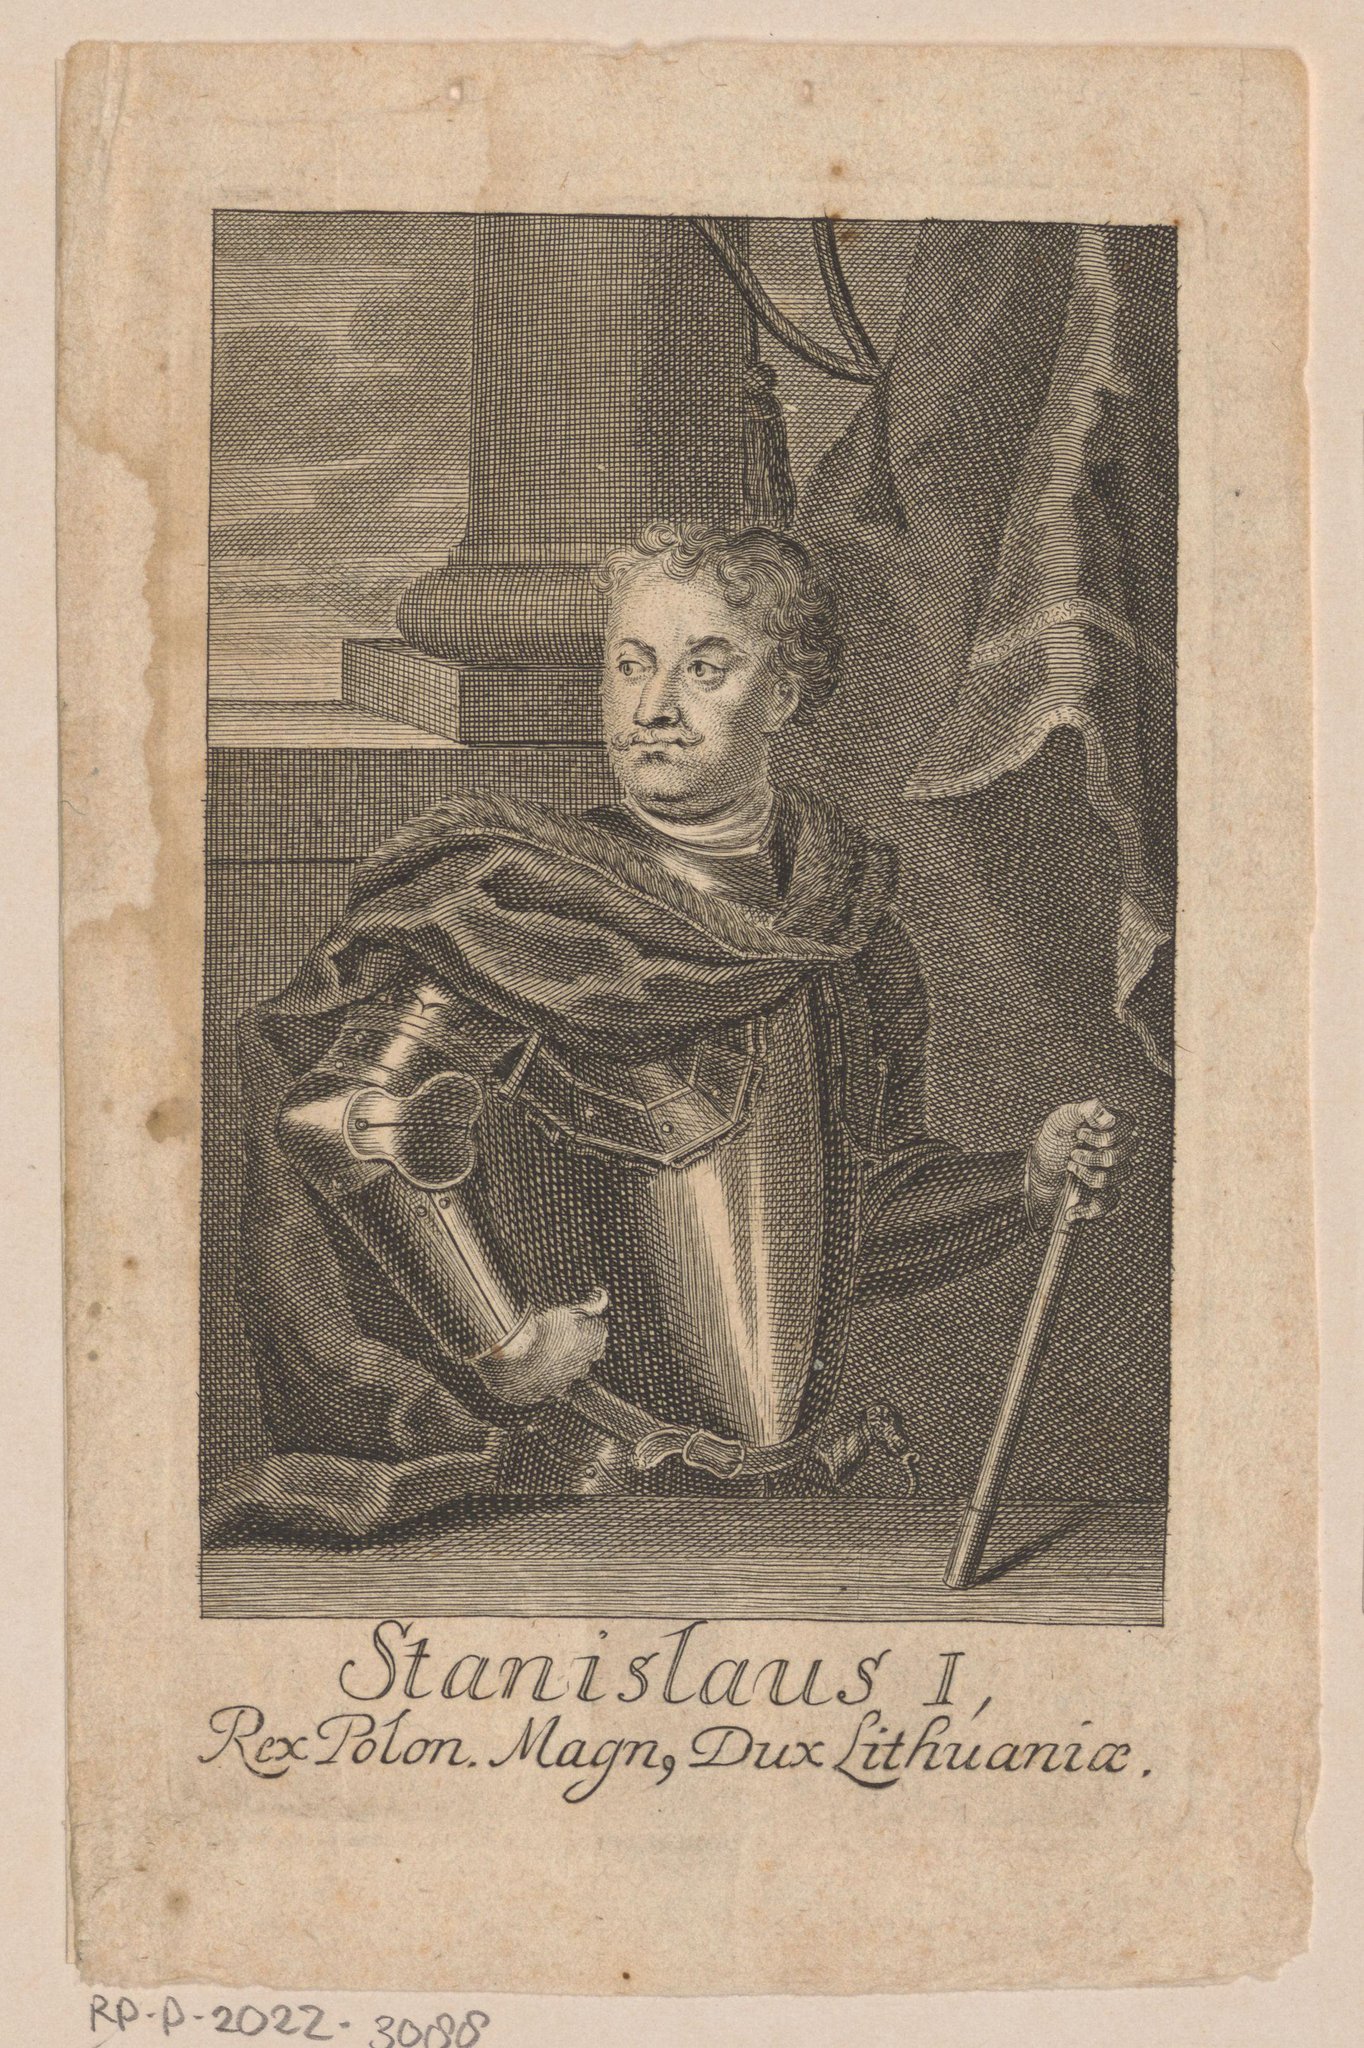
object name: print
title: Portret van Stanislaus Leszczyński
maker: Anonymous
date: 1707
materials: paper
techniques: engraving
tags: historical persons, king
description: Prent waarschijnlijk uit: Die Europäische FAMA. Welche den gegenwärtigen Zustand der vornehmsten Höfe entdecket. S.l.: s.n., 1707, dl. 68